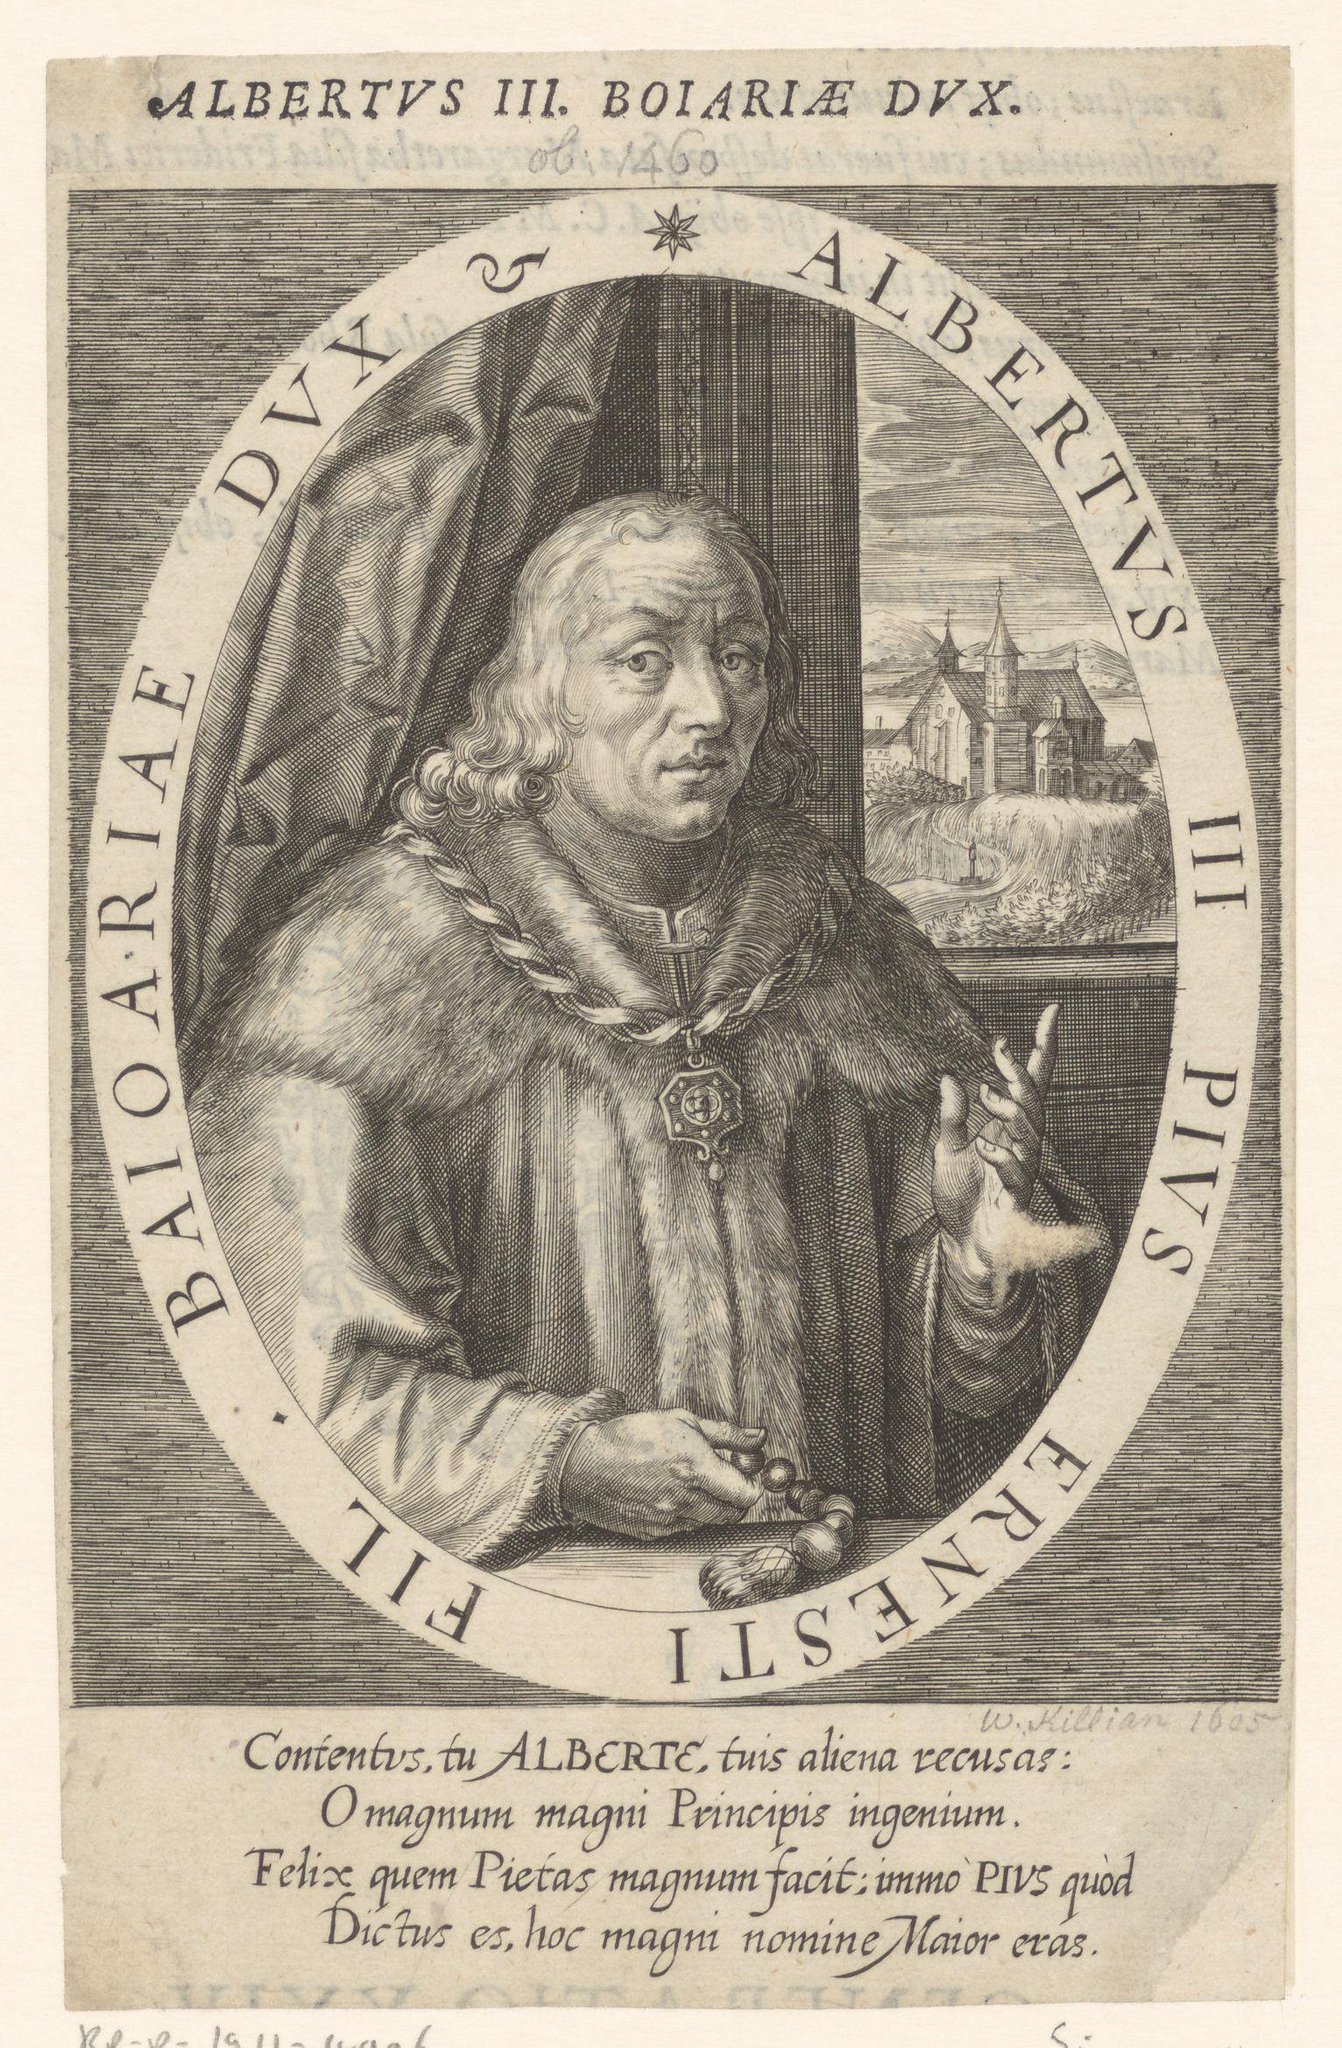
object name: print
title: Portret van Albrecht III van Beieren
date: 1591-1605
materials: paper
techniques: engraving, letterpress printing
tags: historical persons, regent, substitute ruler; viceroy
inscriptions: collector's mark: Lugt 2228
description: Prent gebruikt in een versie van: Custos, Dominicus. Genealogia Serenissimor. Boiariae ducum et quorundam genuinae effigies. S.l. Dominicus Custos,1605.